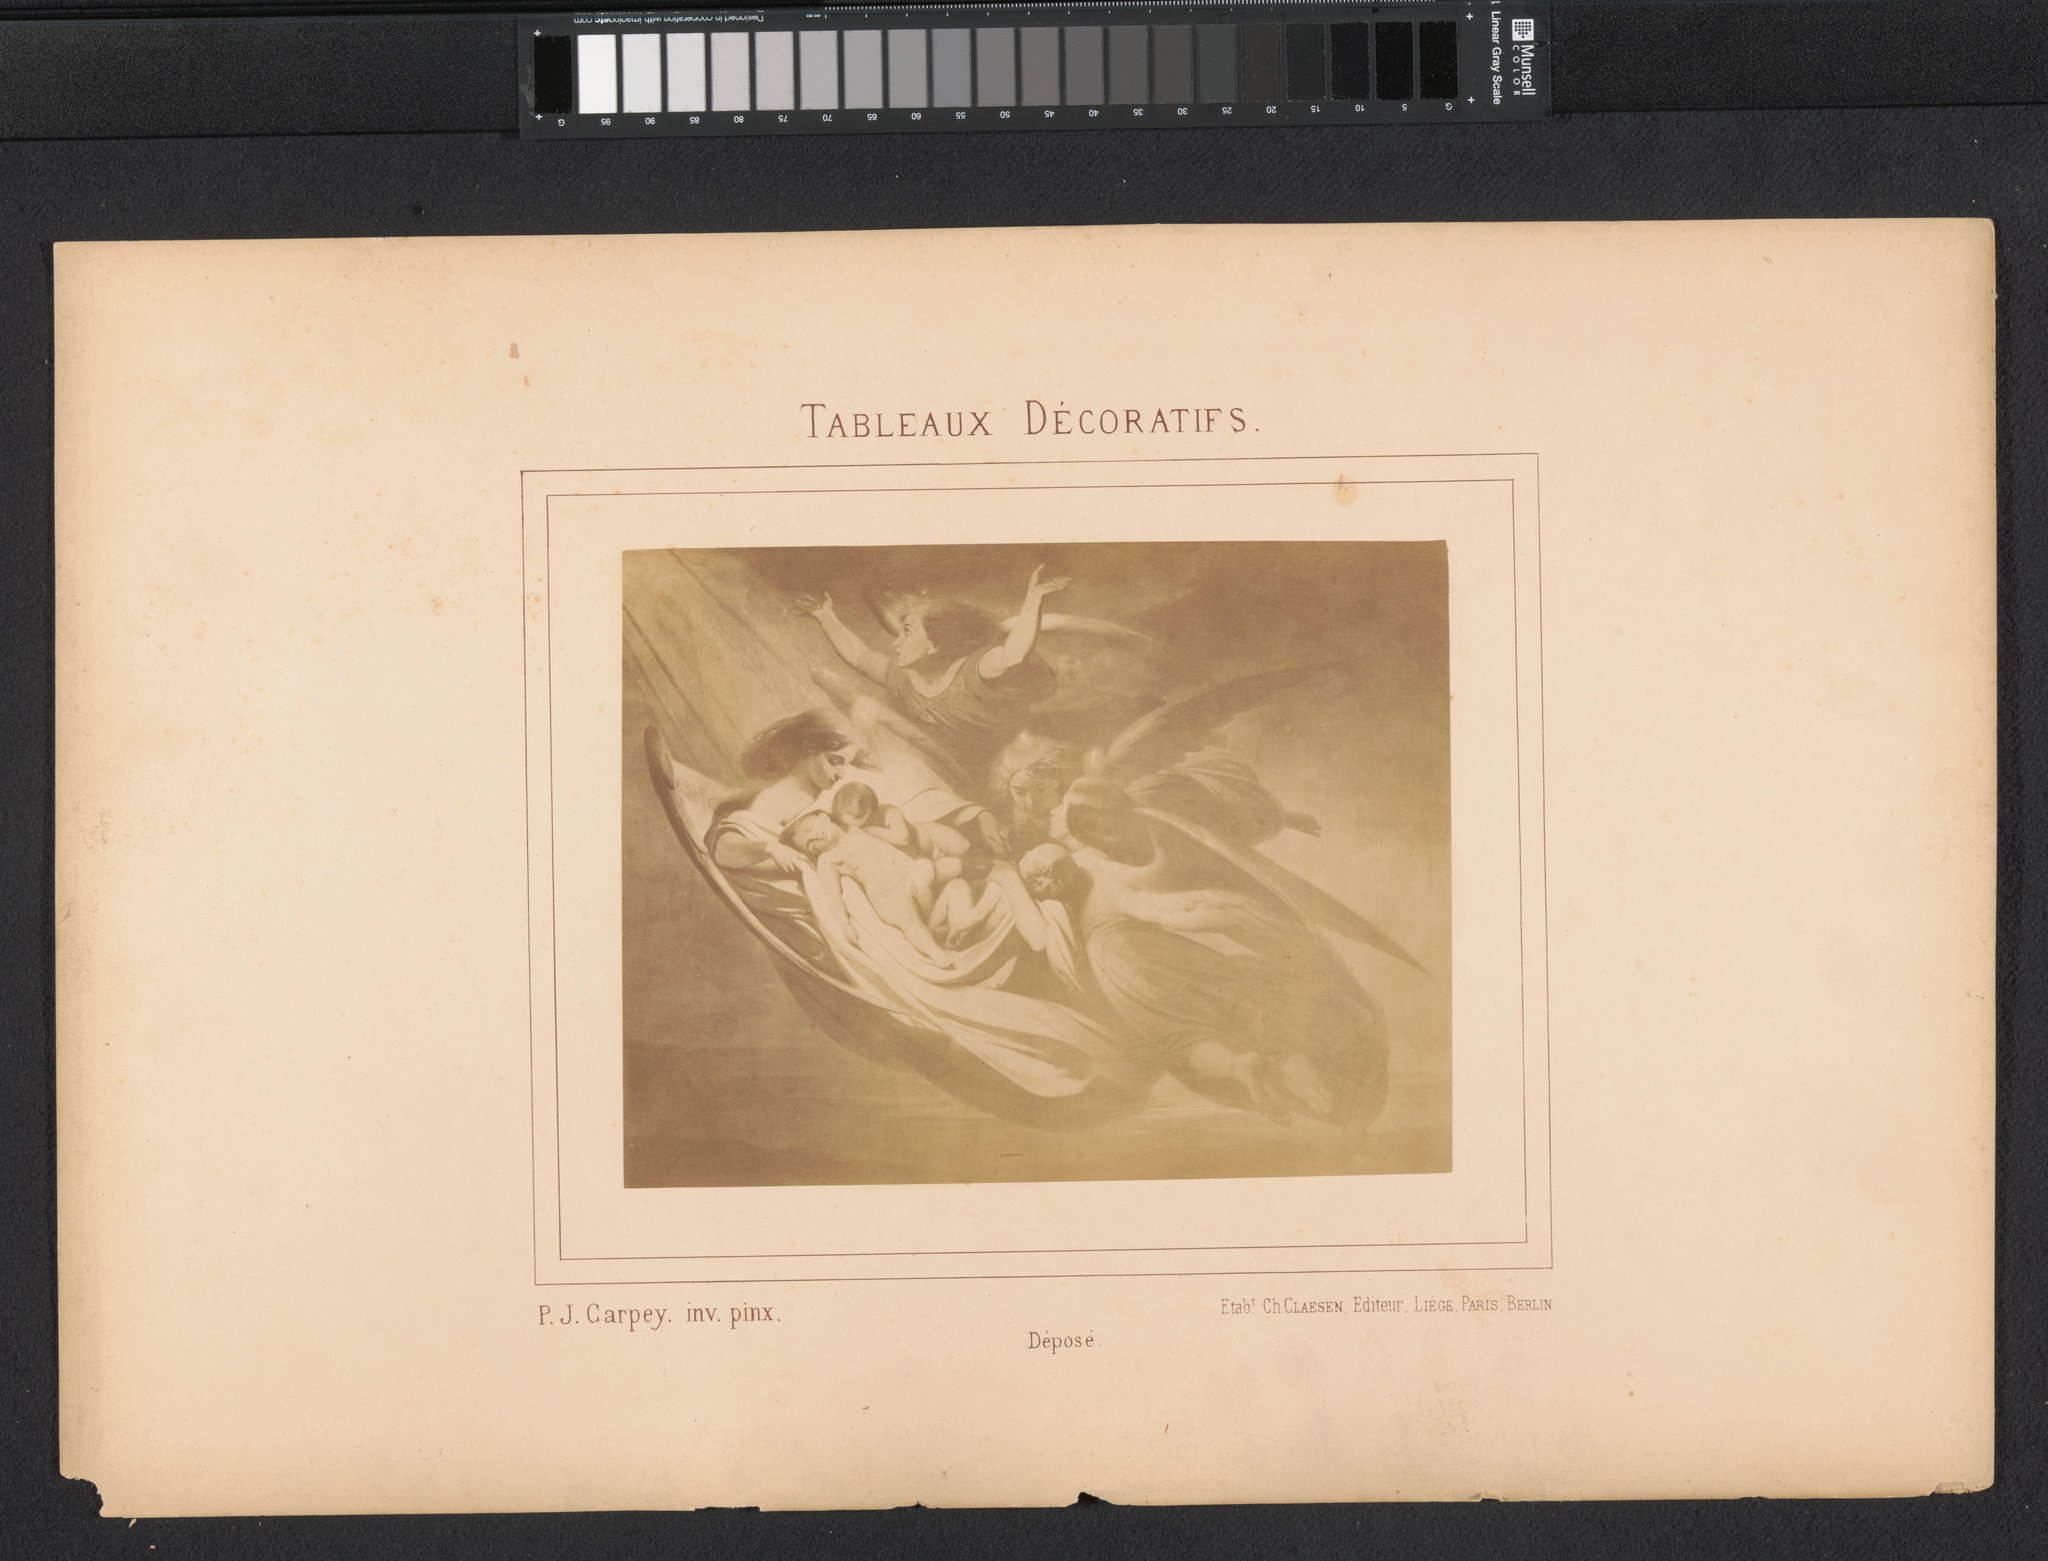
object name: reproduction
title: Fotoreproductie van een schilderij van een vrouw met drie kinderen en drie engelen door P. J. Carpey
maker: paul-joseph carpay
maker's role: painter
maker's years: 1822-1892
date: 1874-1881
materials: photographic support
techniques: albumen print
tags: mother and child(ren), woman and child(ren) (family group), angels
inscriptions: inscription: ‘Etabt. Ch. Claesen , Editeur , Liége , Paris , Berlin’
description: Deze foto maakt deel uit van een omslag met 24 foto's op 22 bladen.